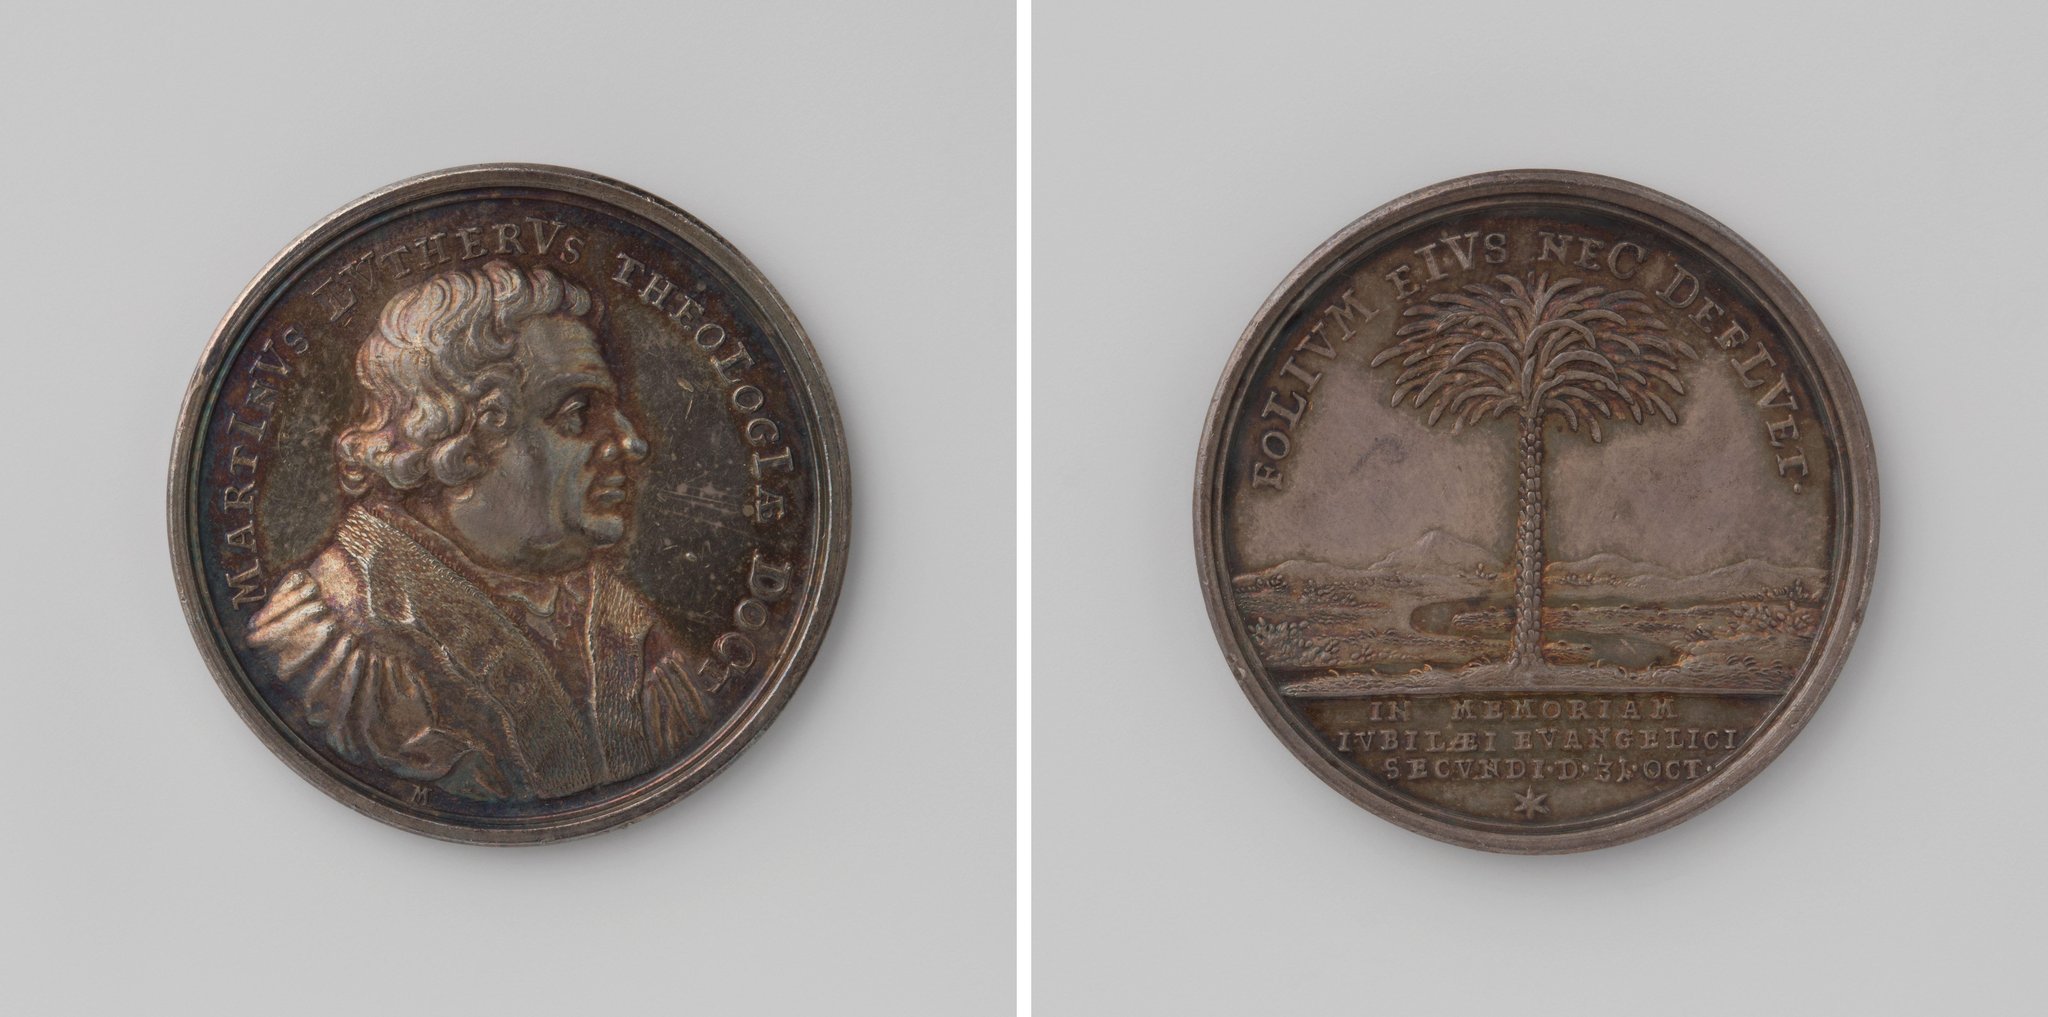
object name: history medal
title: Tweede eeuwfeest van de Reformatie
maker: philipp heinrich müller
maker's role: medailleur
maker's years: 1654-1719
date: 1717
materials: silver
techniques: striking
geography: nuremberg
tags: priest, martin luther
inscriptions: caption: ‘IN MEMORIAM/ IVBILÆI EVANGELICI/ SECVNDI . D . 31 . OCT .’, circumscription: ‘MARTINUS LVTHERUS THEOLOGIAE DOCT.’, circumscription: ‘FOLIVM EIVS NEC DEFLVET.’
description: Zilveren penning. Voorzijde: borststuk man binnen omschrift. Keerzijde: palmboom met op achtergrond berglandschap binnen omschrift; afsnede: opschrift.